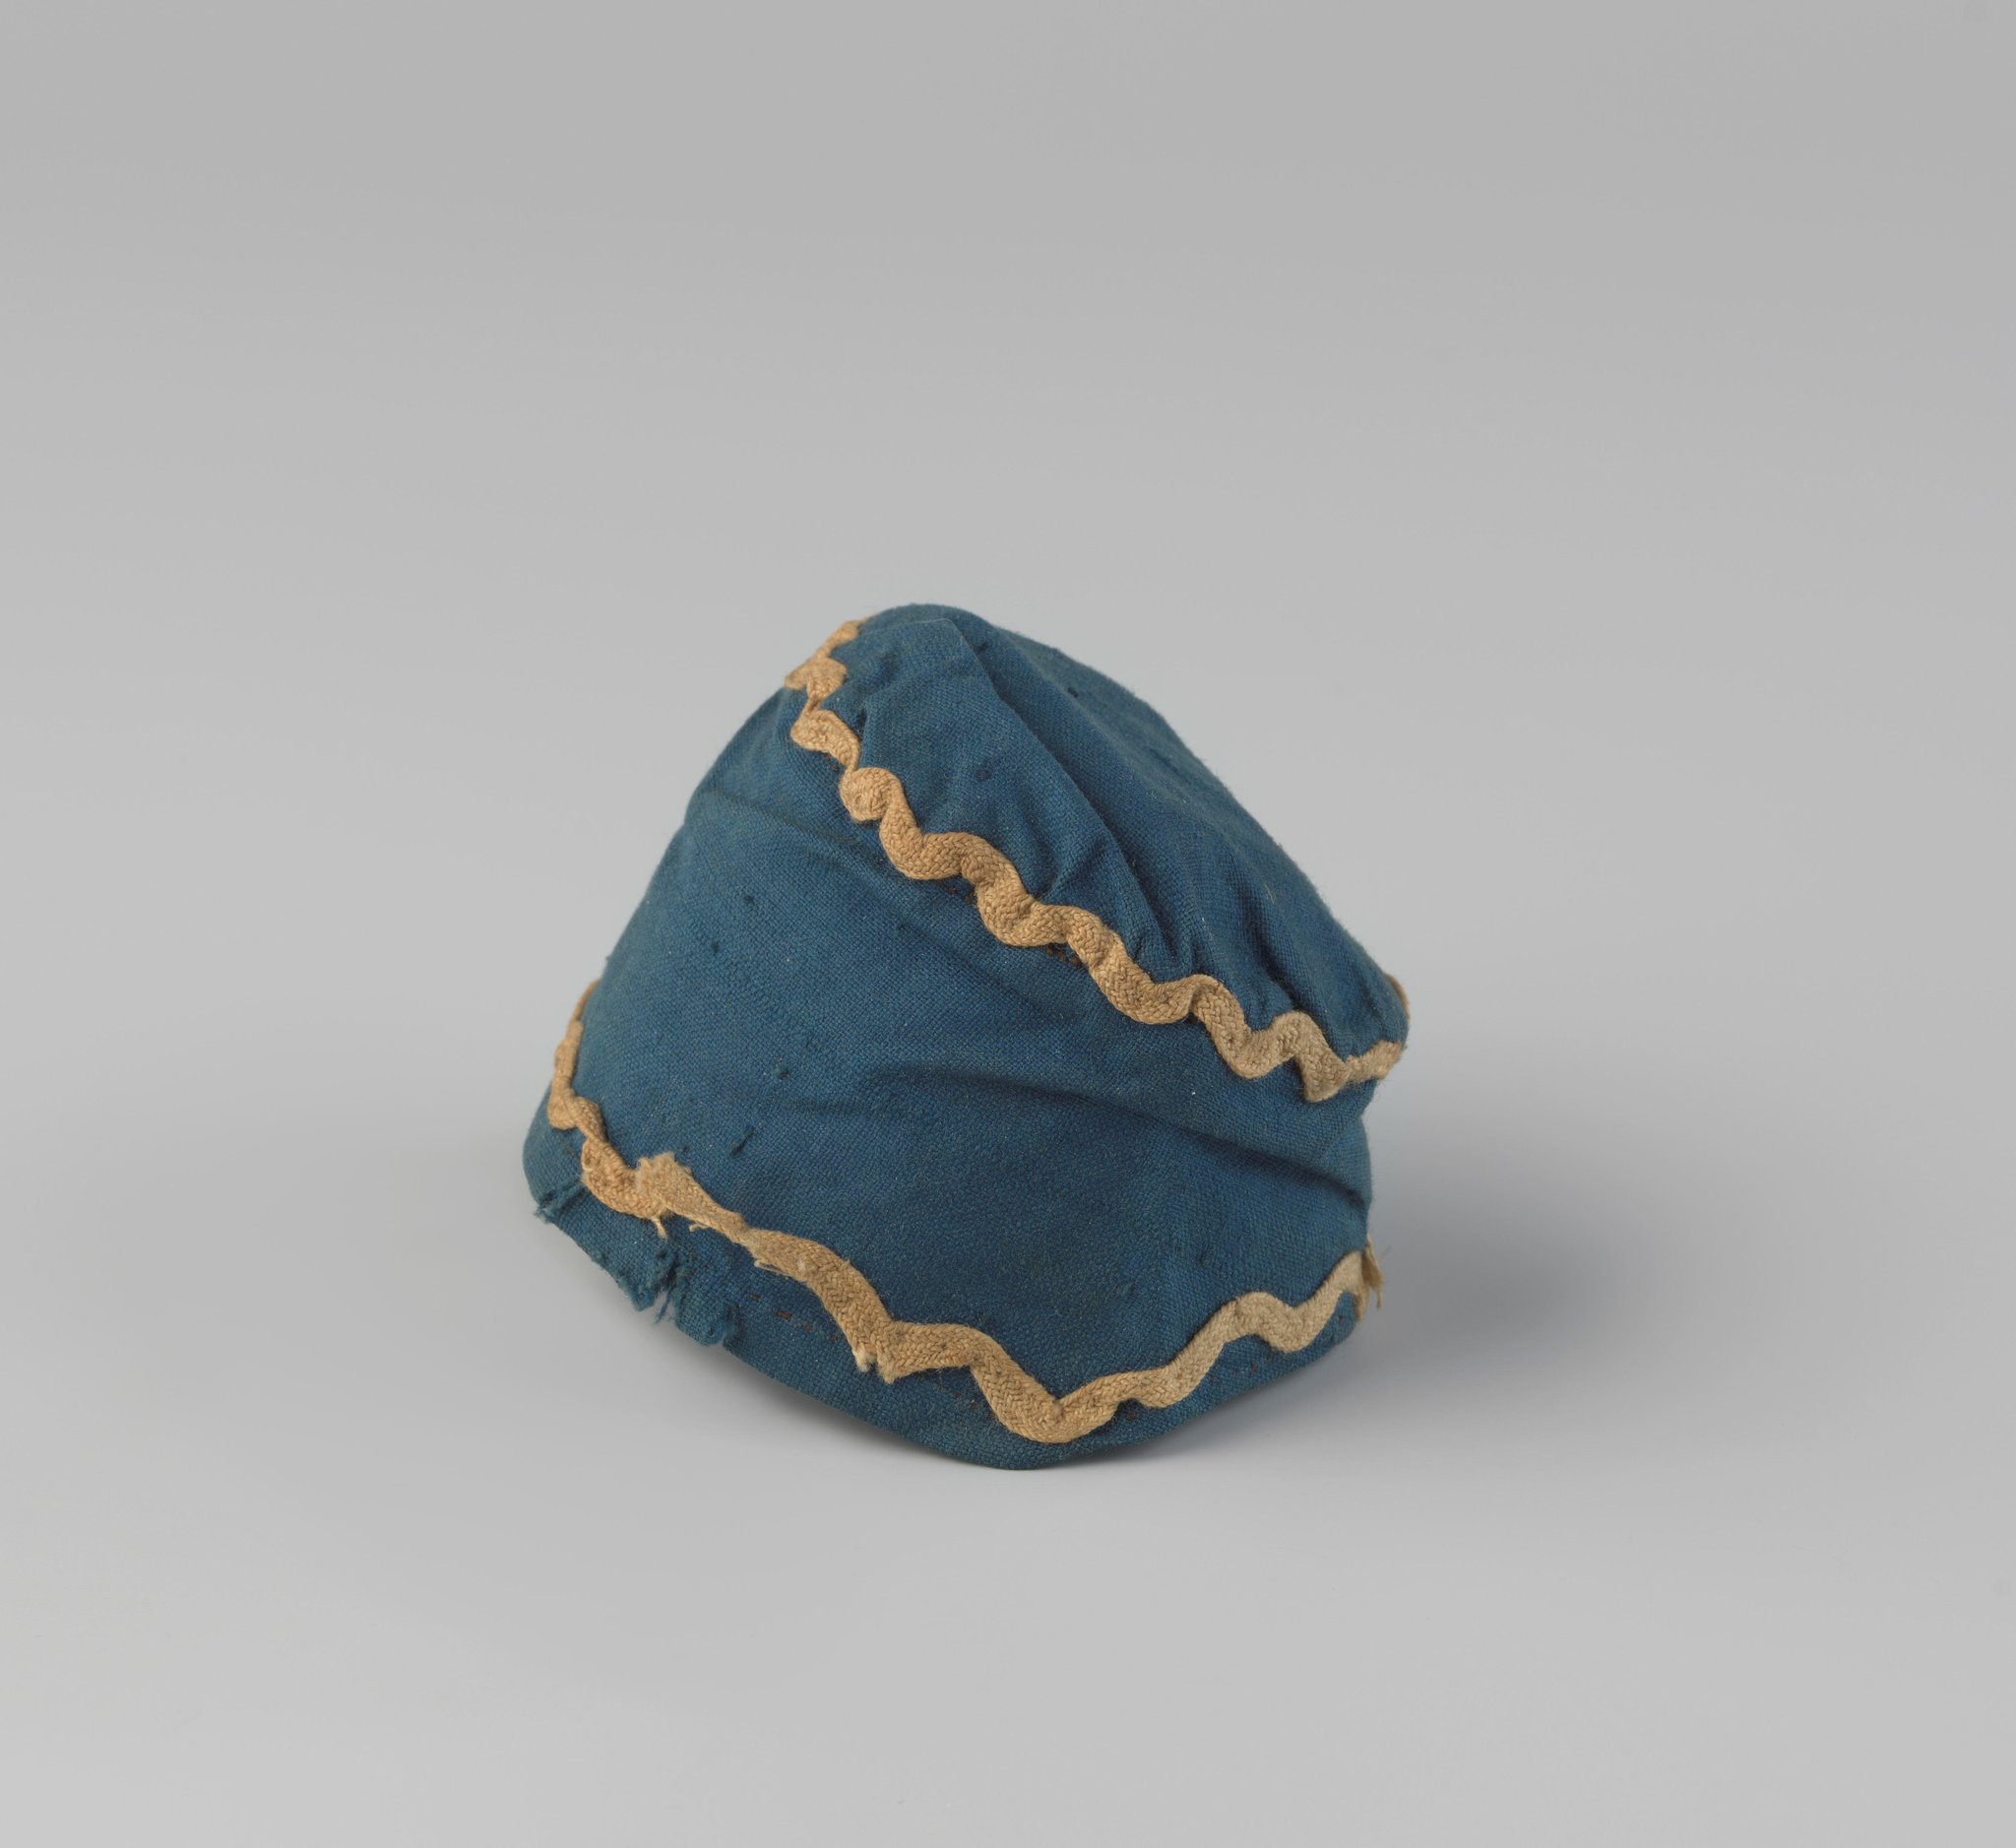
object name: hat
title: Hoed van zwart textiel met olijfgroene linten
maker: Anonymous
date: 1850-1940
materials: textile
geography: europe